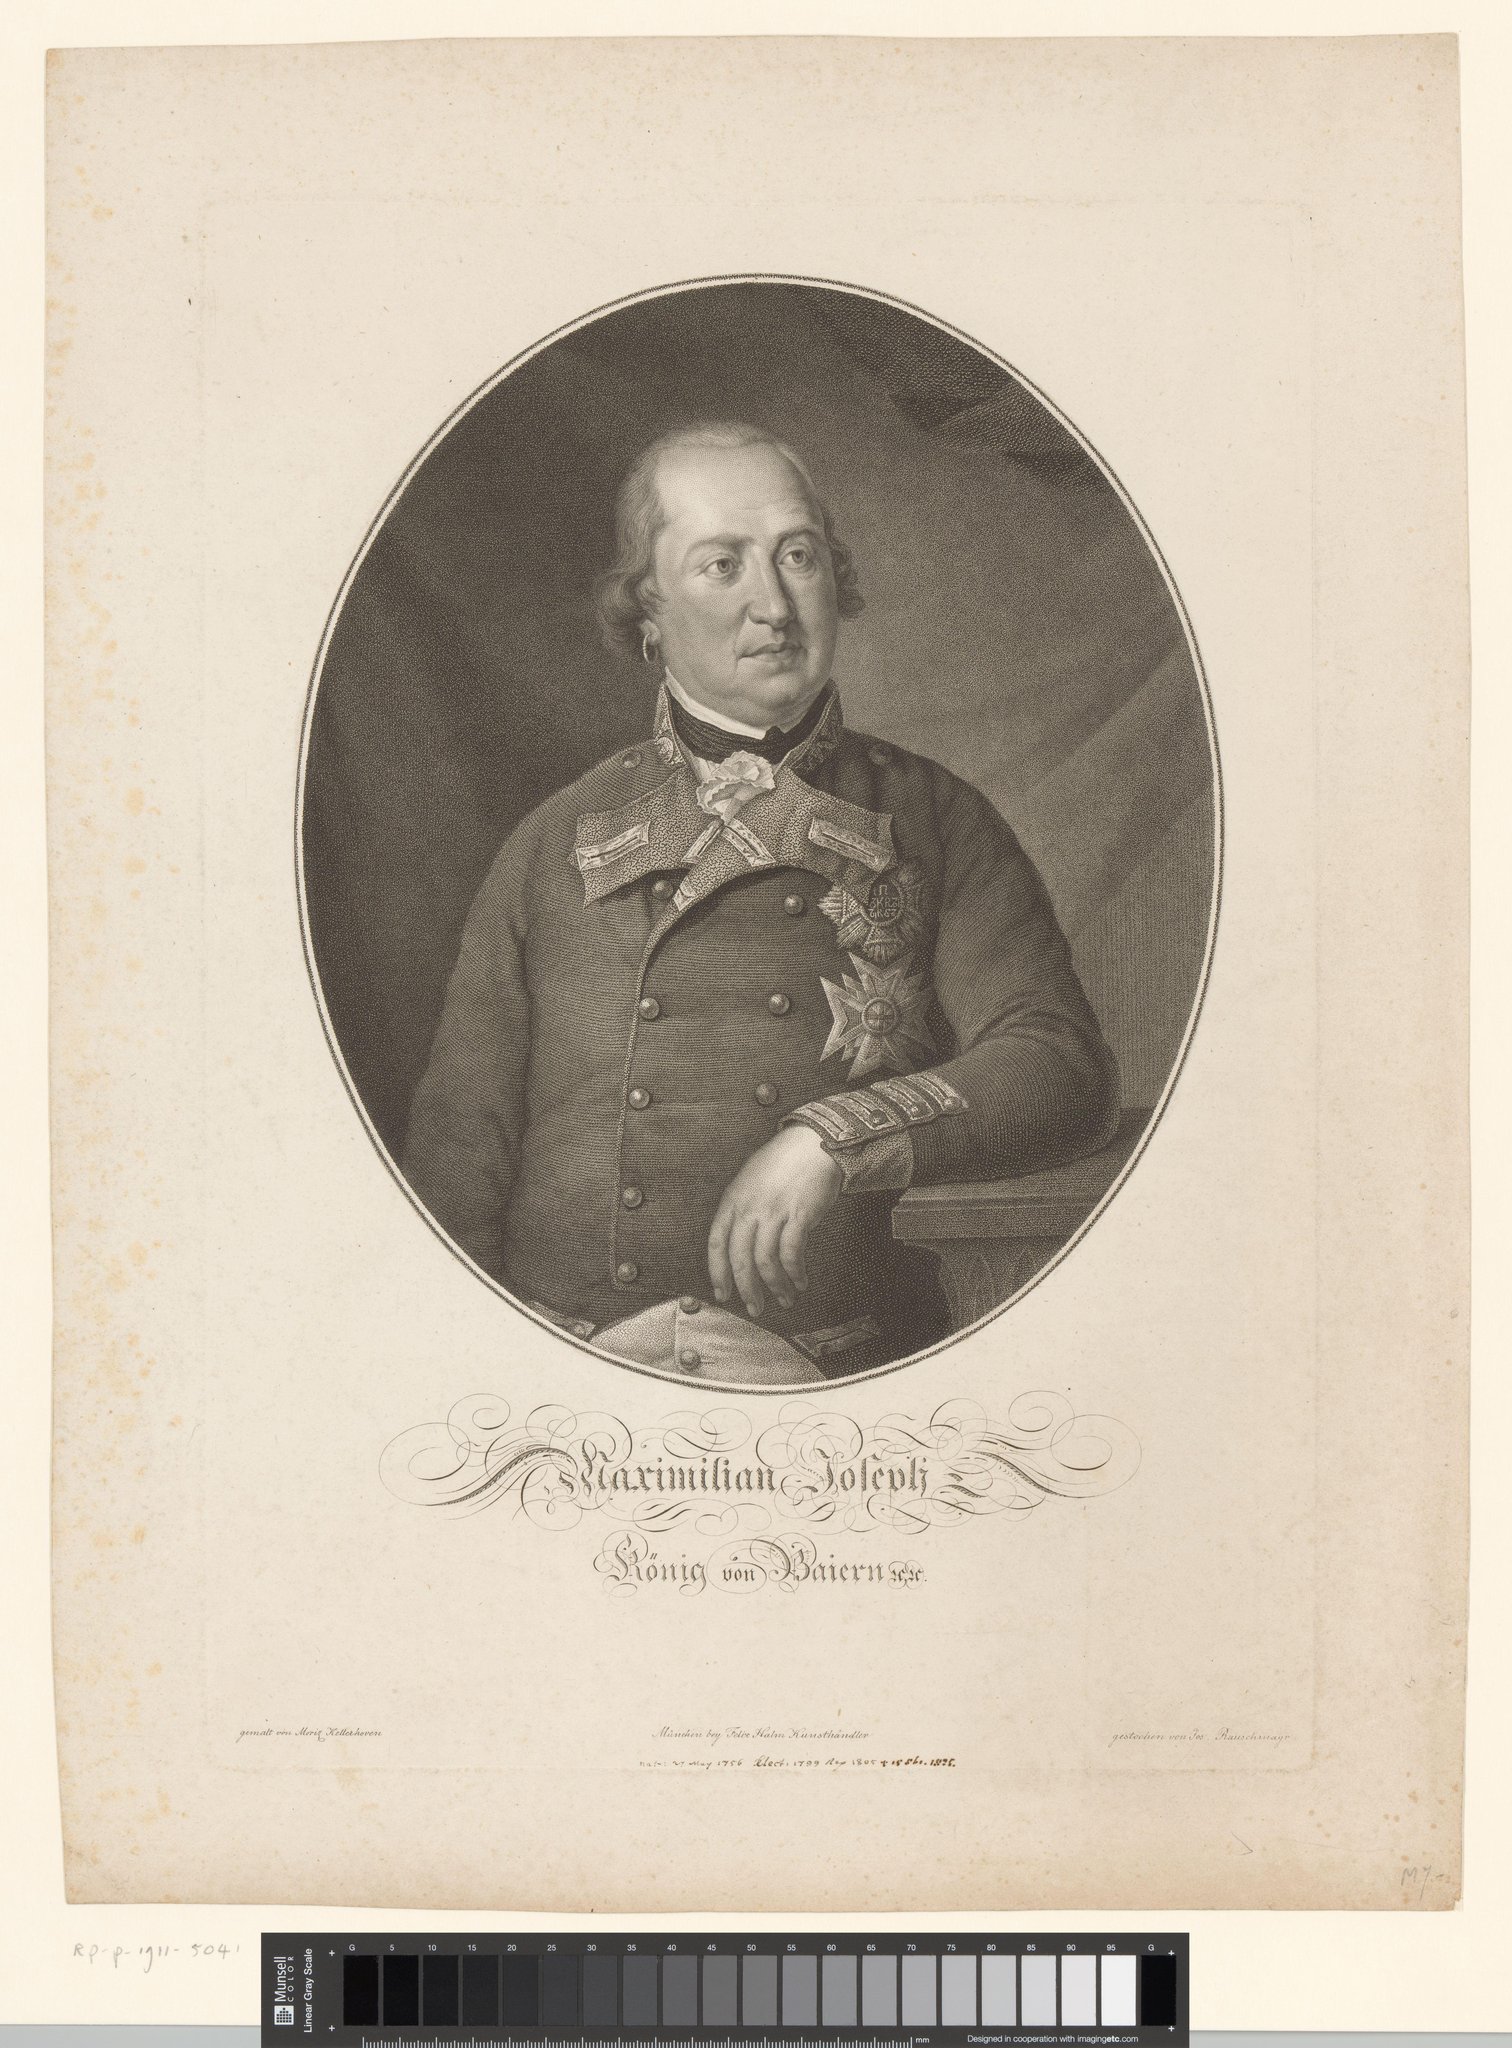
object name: print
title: Portret van Maximiliaan I Jozef, koning van Beieren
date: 1799-1815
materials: paper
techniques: engraving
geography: munich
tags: maximiliaan i jozef (koning van beieren), historical persons, medals and other marks of military honour, ear-rings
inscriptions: collector's mark: Lugt 2228